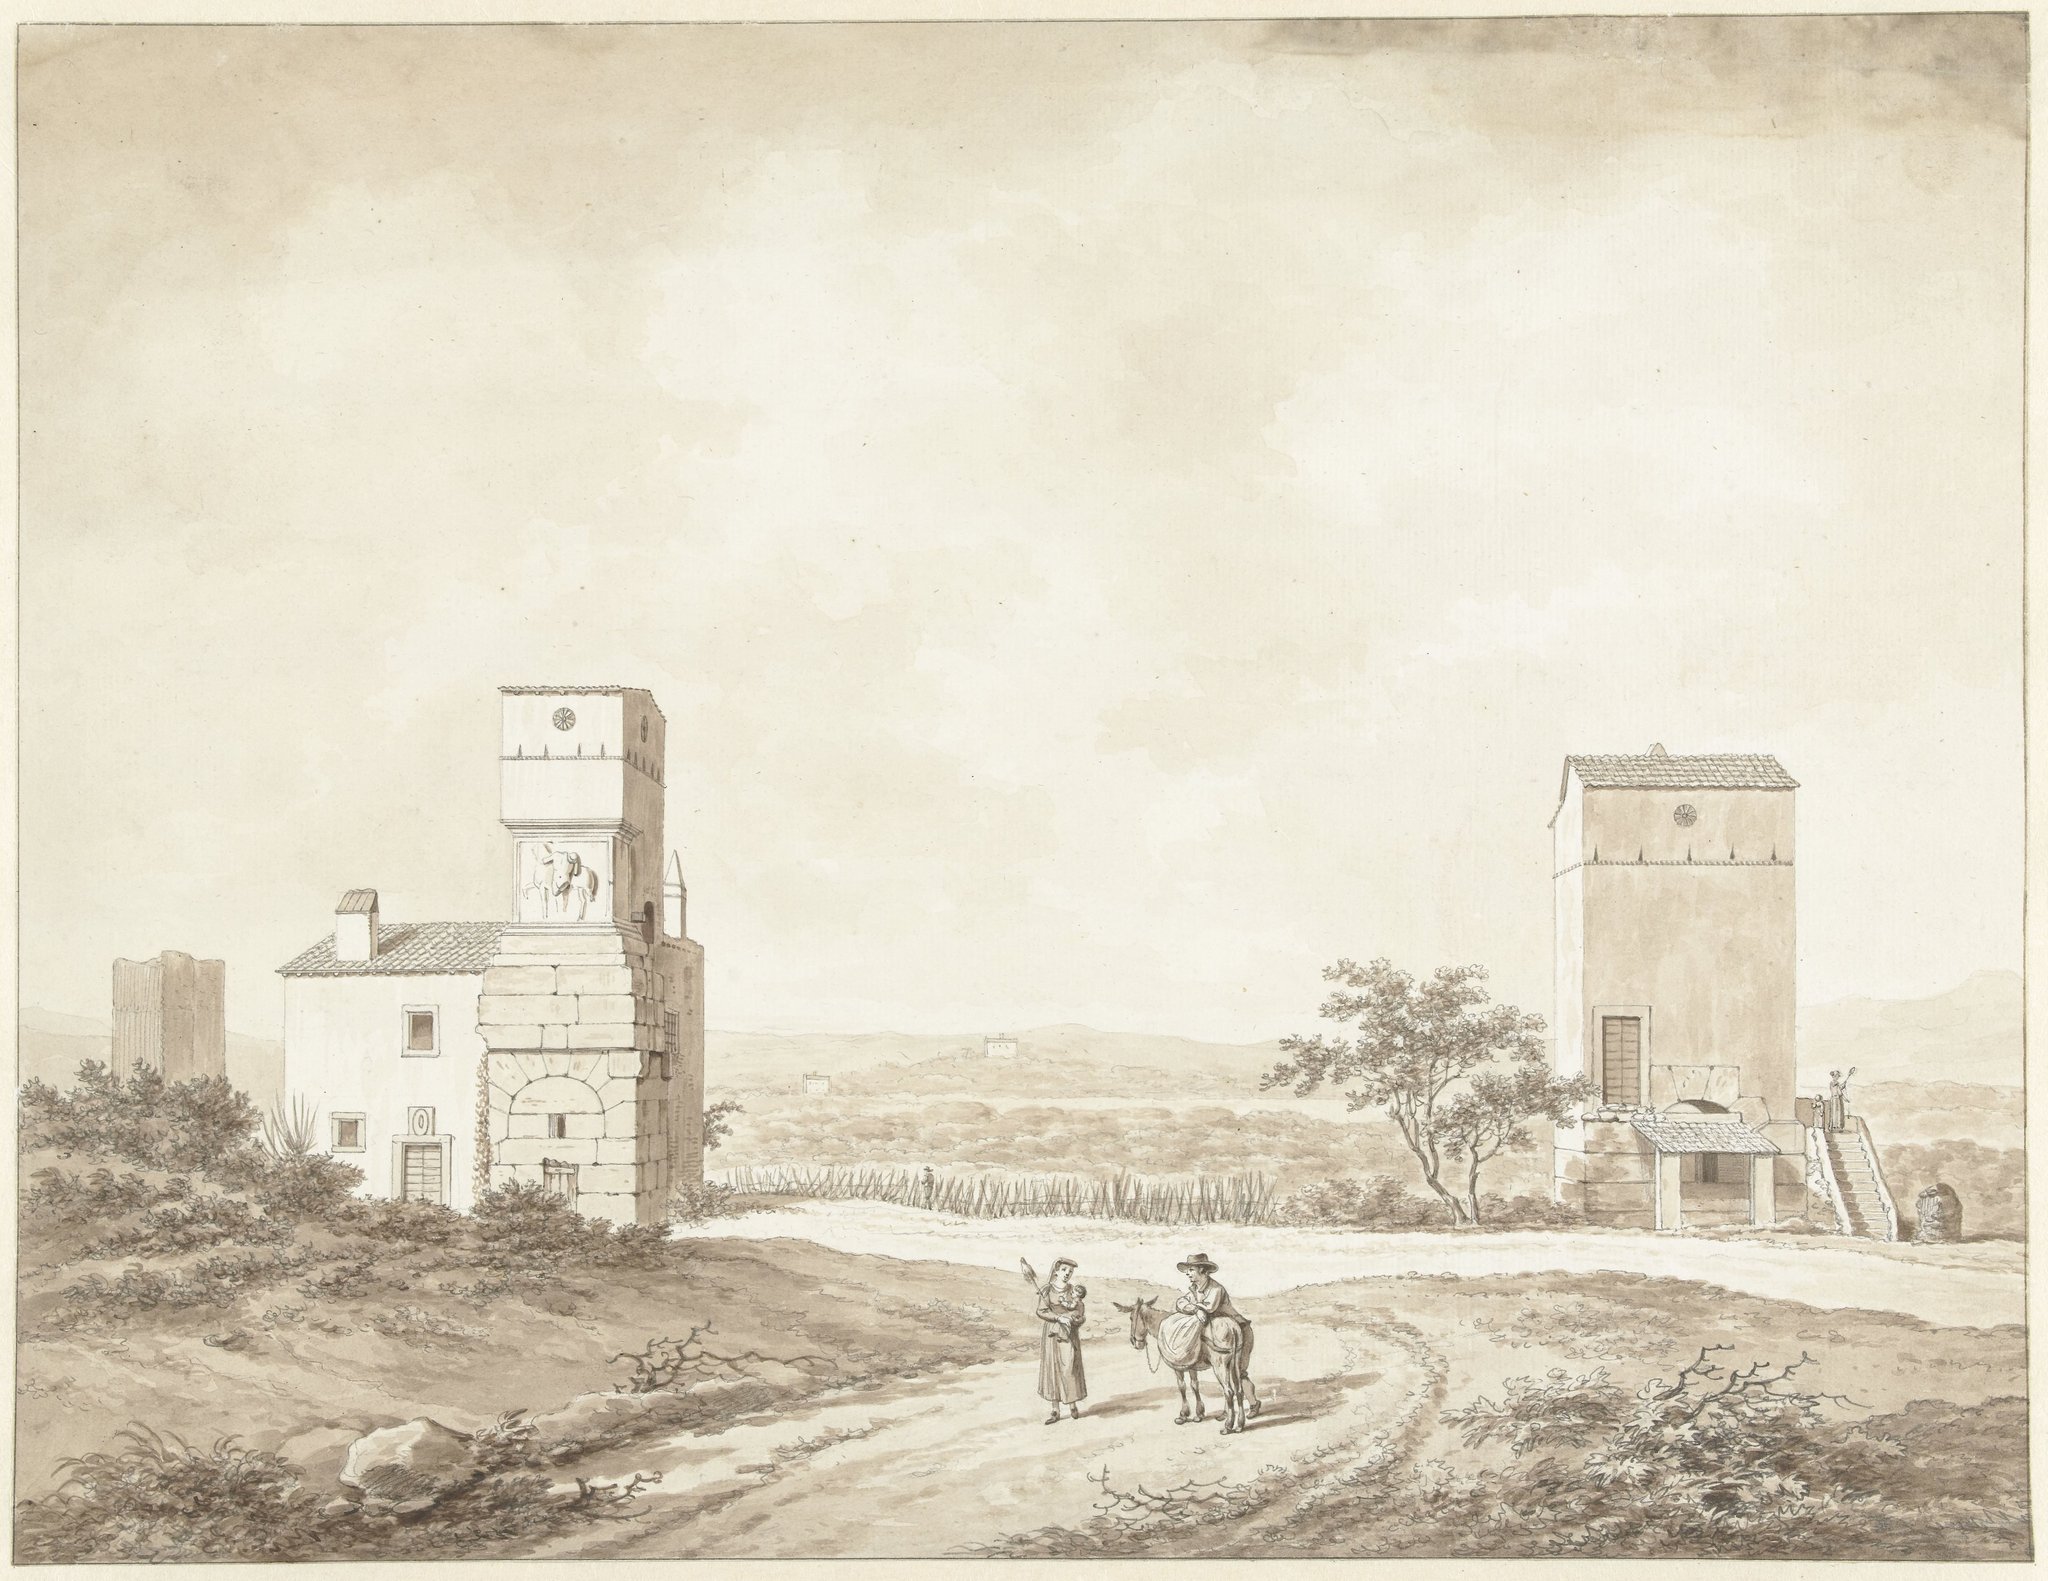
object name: drawing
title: Ruïnes van de Villa Adriana nabij Tivoli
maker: daniël dupré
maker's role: draughtsman, print maker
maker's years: 1751-1817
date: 1761-1817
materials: ink, paper, pencil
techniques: brush, pen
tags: landscape with ruins, italy